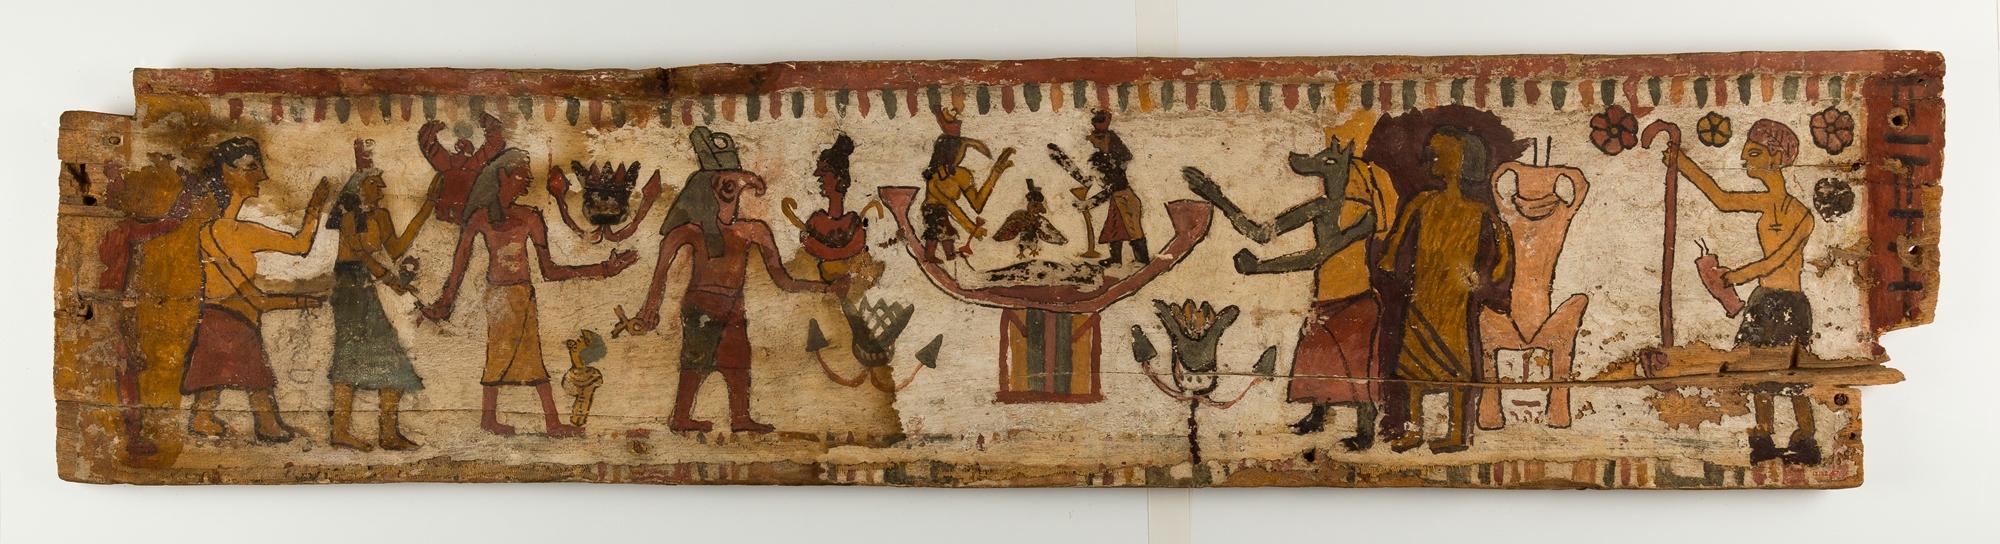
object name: coffin panel painting, funerary ritual, offering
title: Coffin panel with paintings of funerary rituals and gods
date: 100-300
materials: gesso, paint, wood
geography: egypt